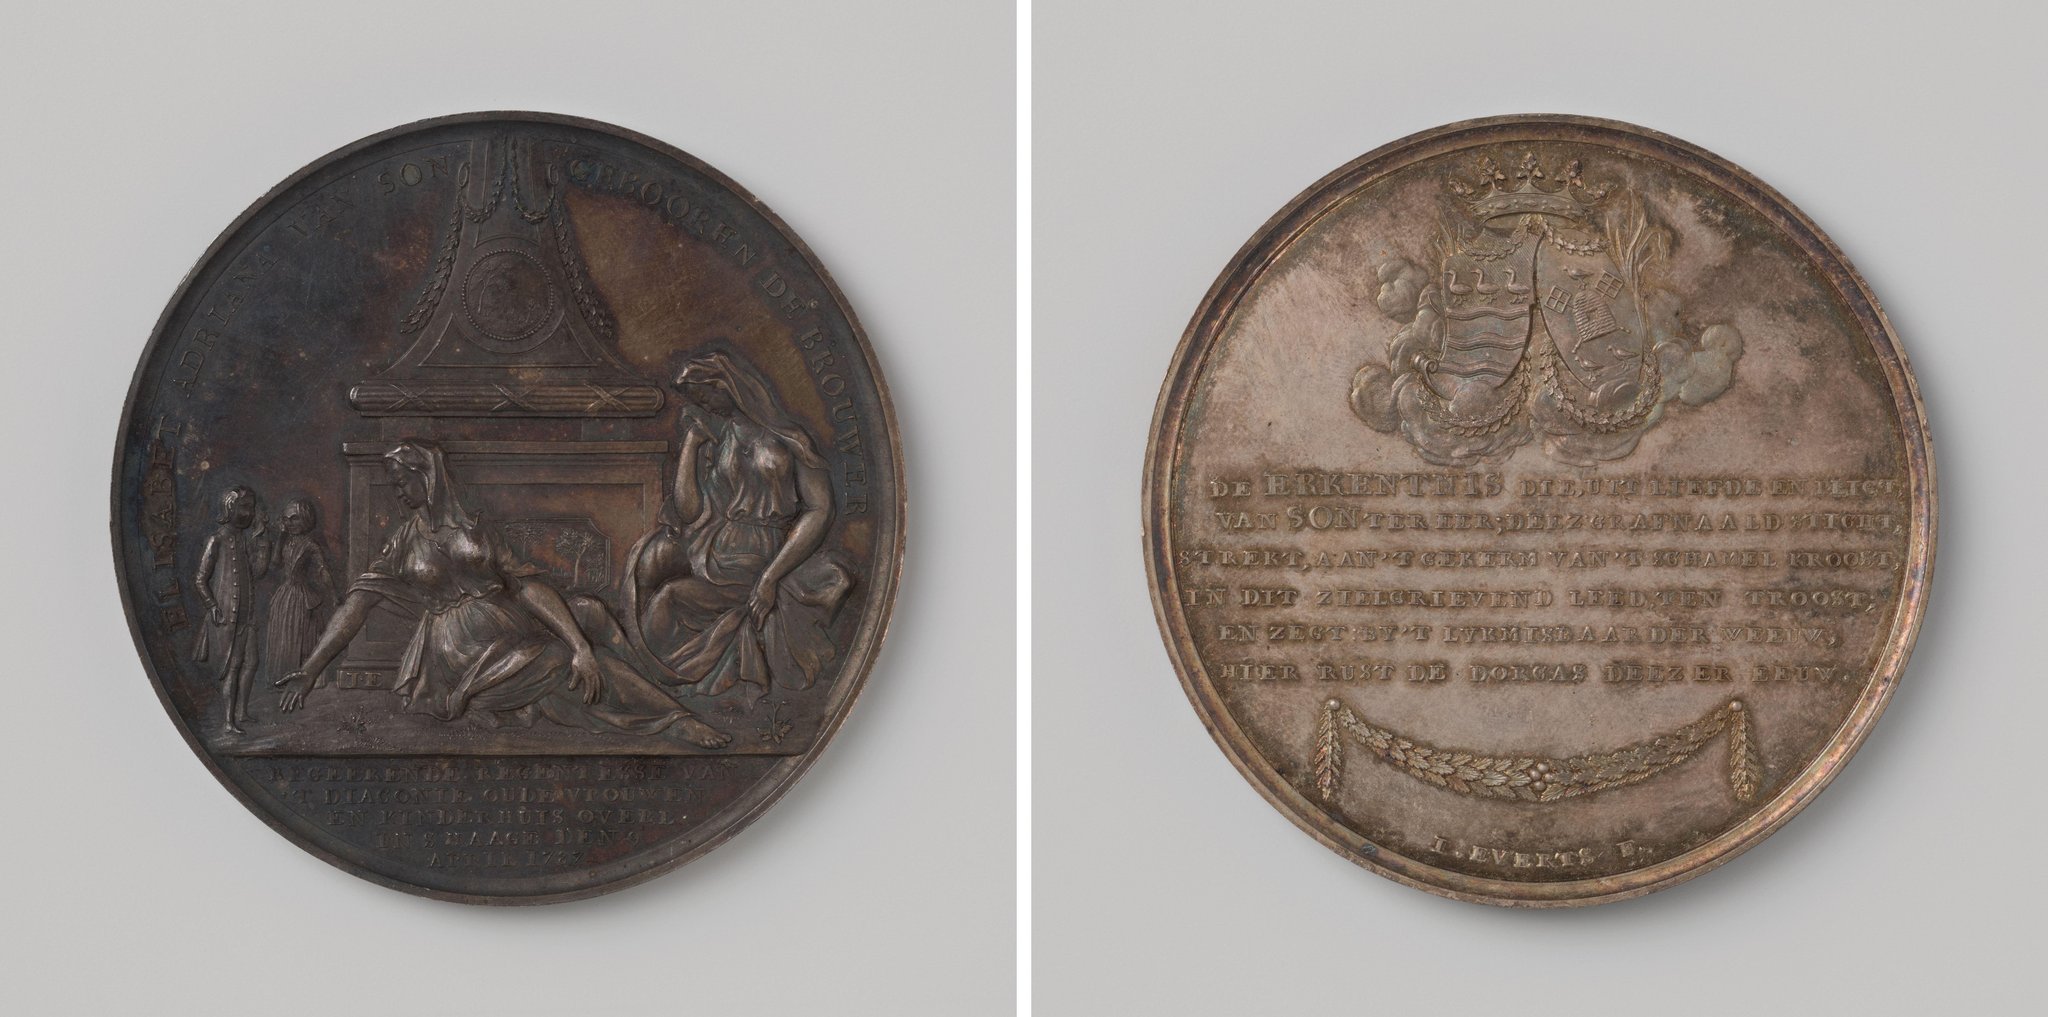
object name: family medal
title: Overlijden van Elisabet Adriana van Son-de Brouwer, regentes van het Diaconie Oude Vrouwen- en Kinderenhuis te 's-Gravenhage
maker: joseph jansz. everts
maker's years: 1784-1807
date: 1787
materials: silver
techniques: striking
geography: dordrecht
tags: the hague